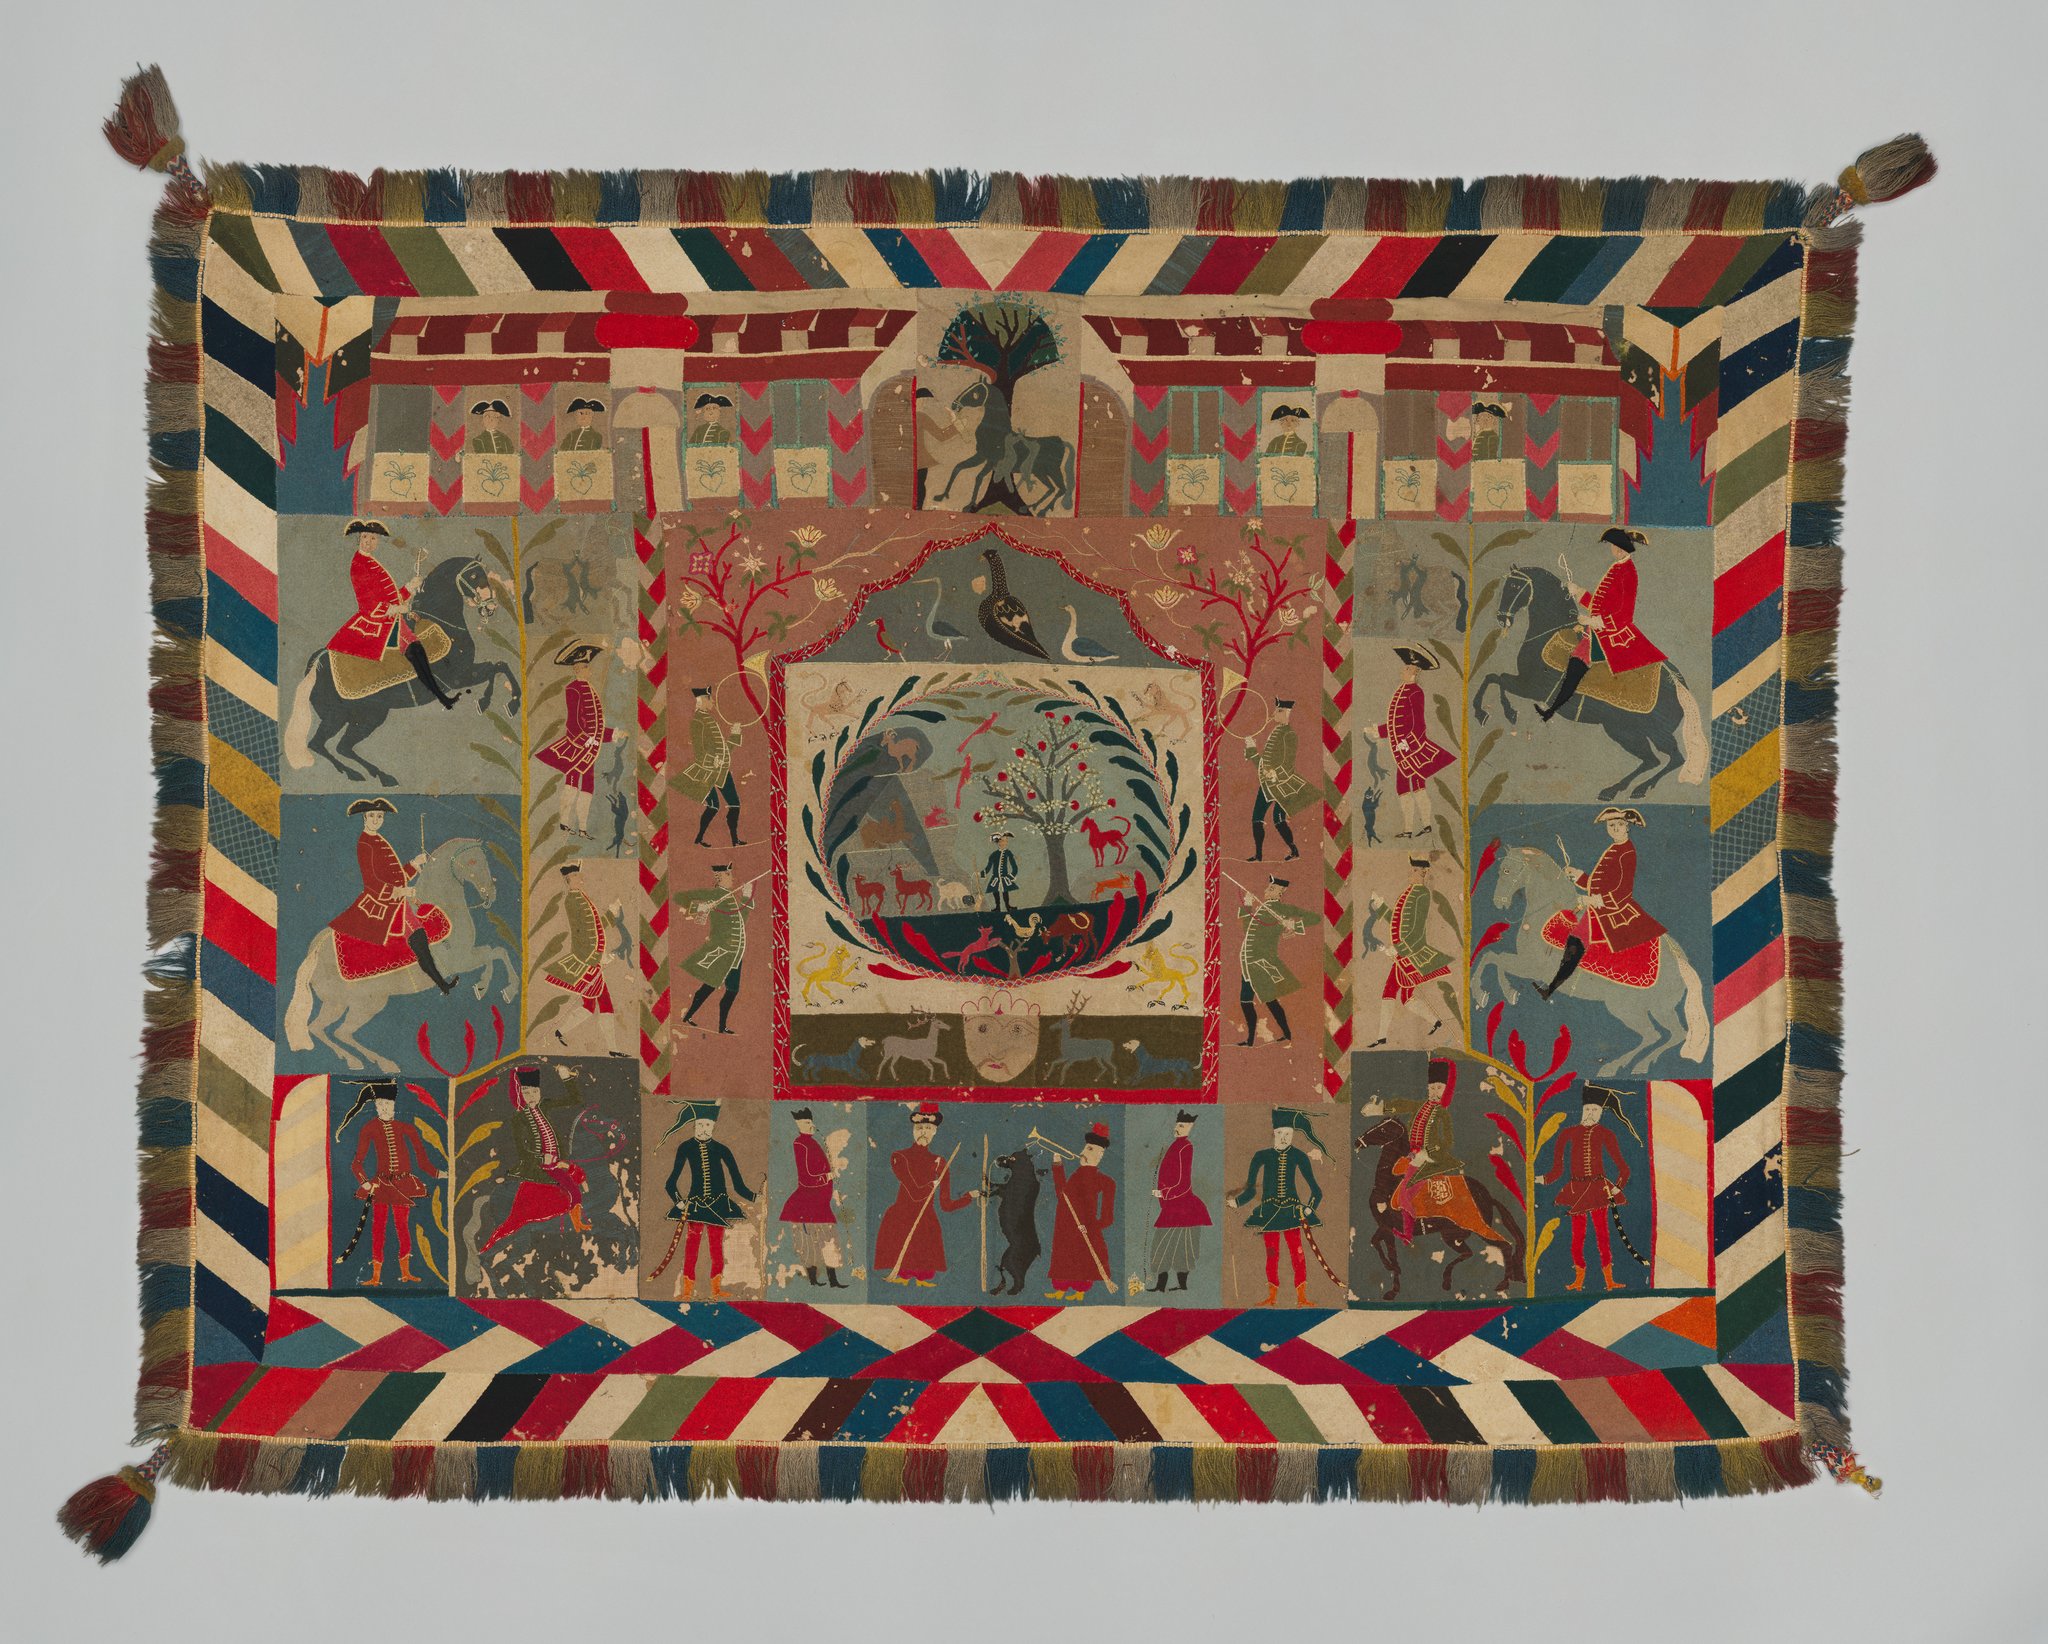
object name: cover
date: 1701-1800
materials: silk, wool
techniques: embroidery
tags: men,music,deer,horses